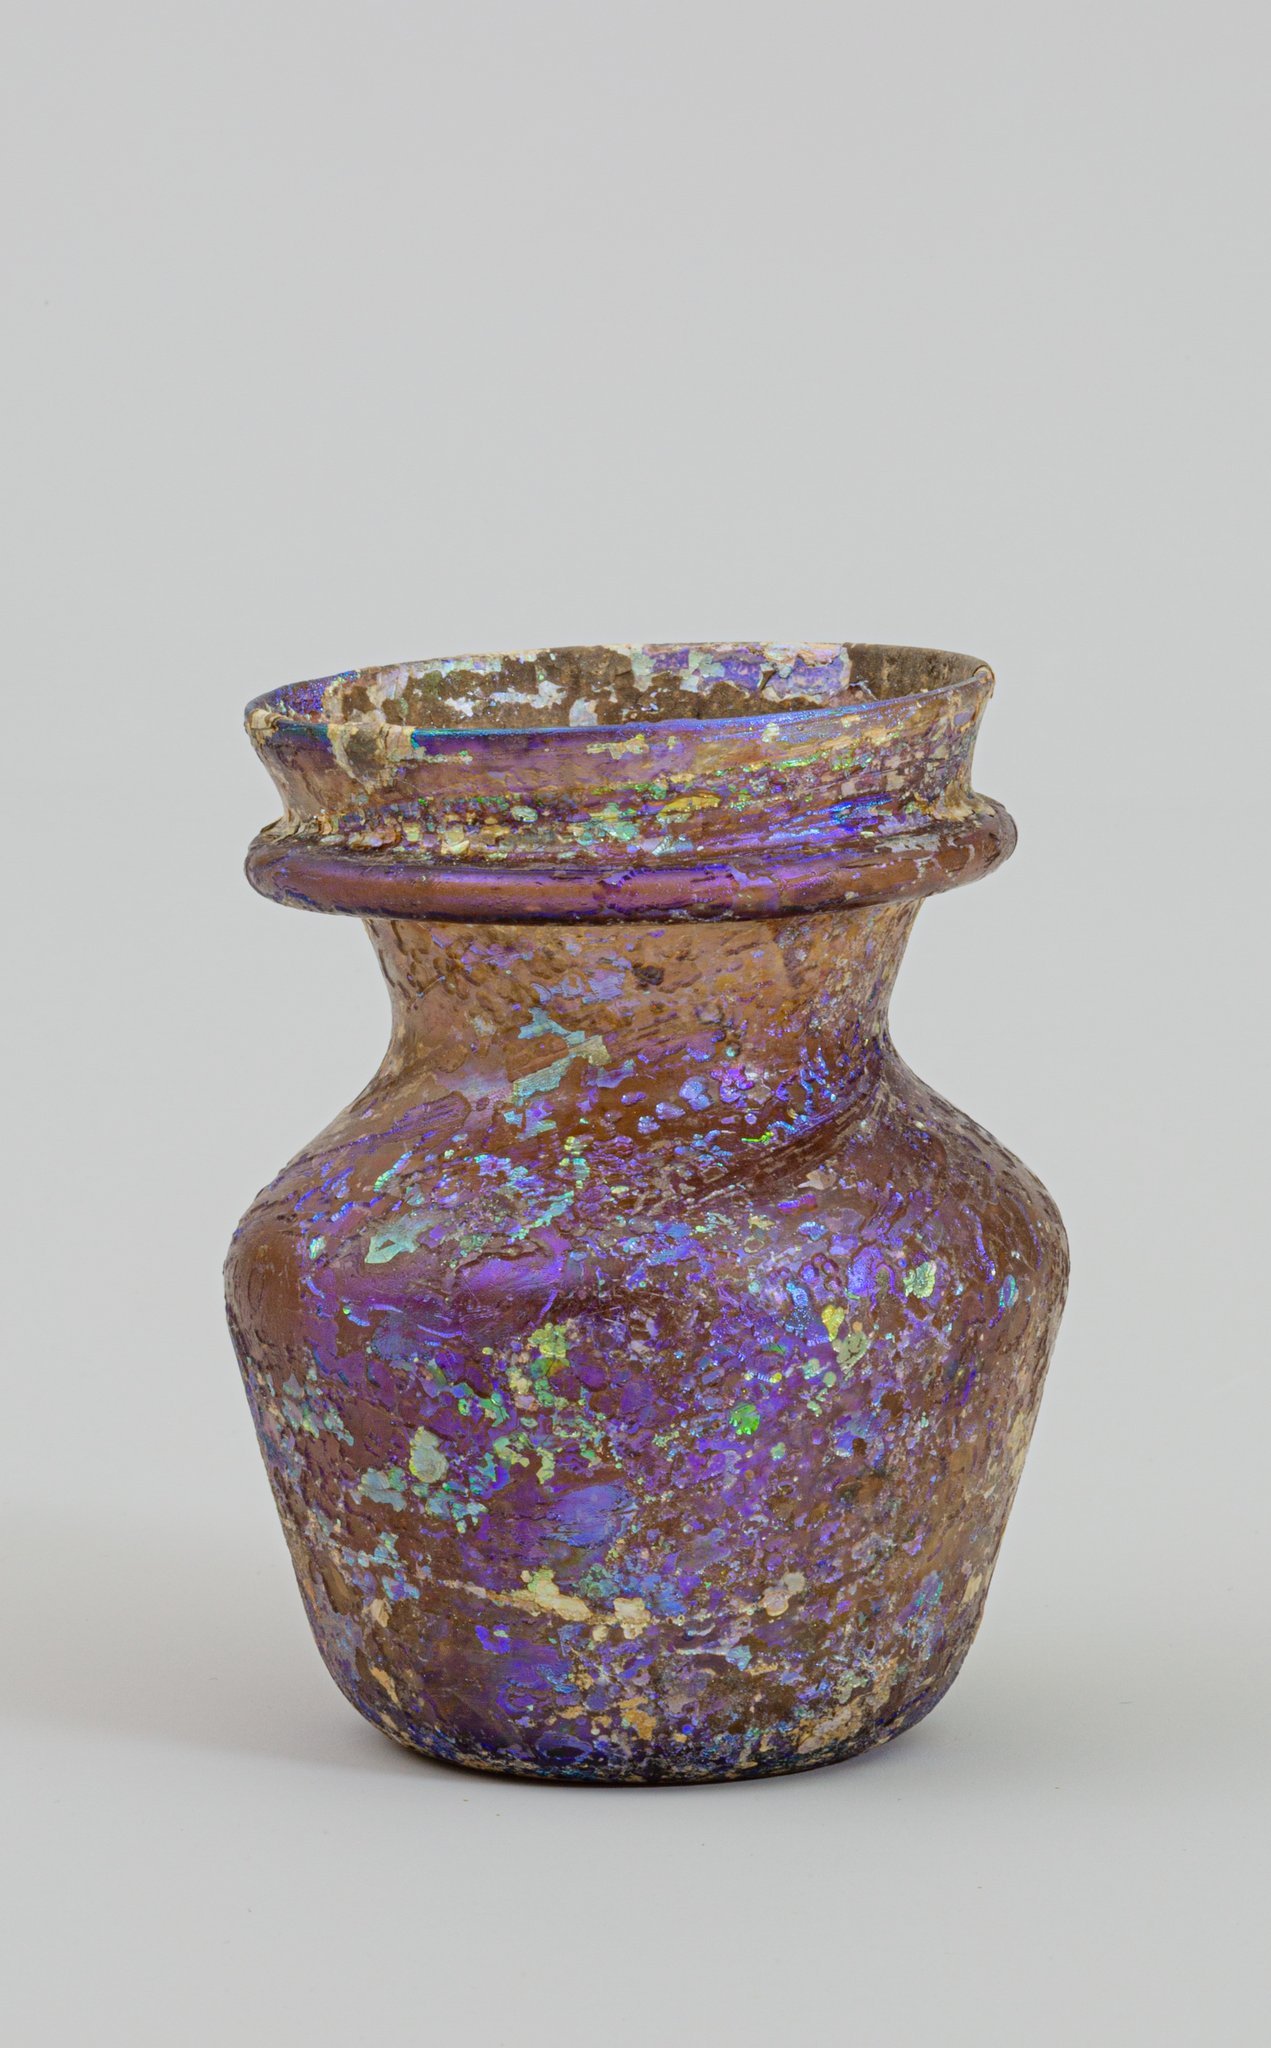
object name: jar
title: Glass jar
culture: roman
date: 301-500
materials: glass